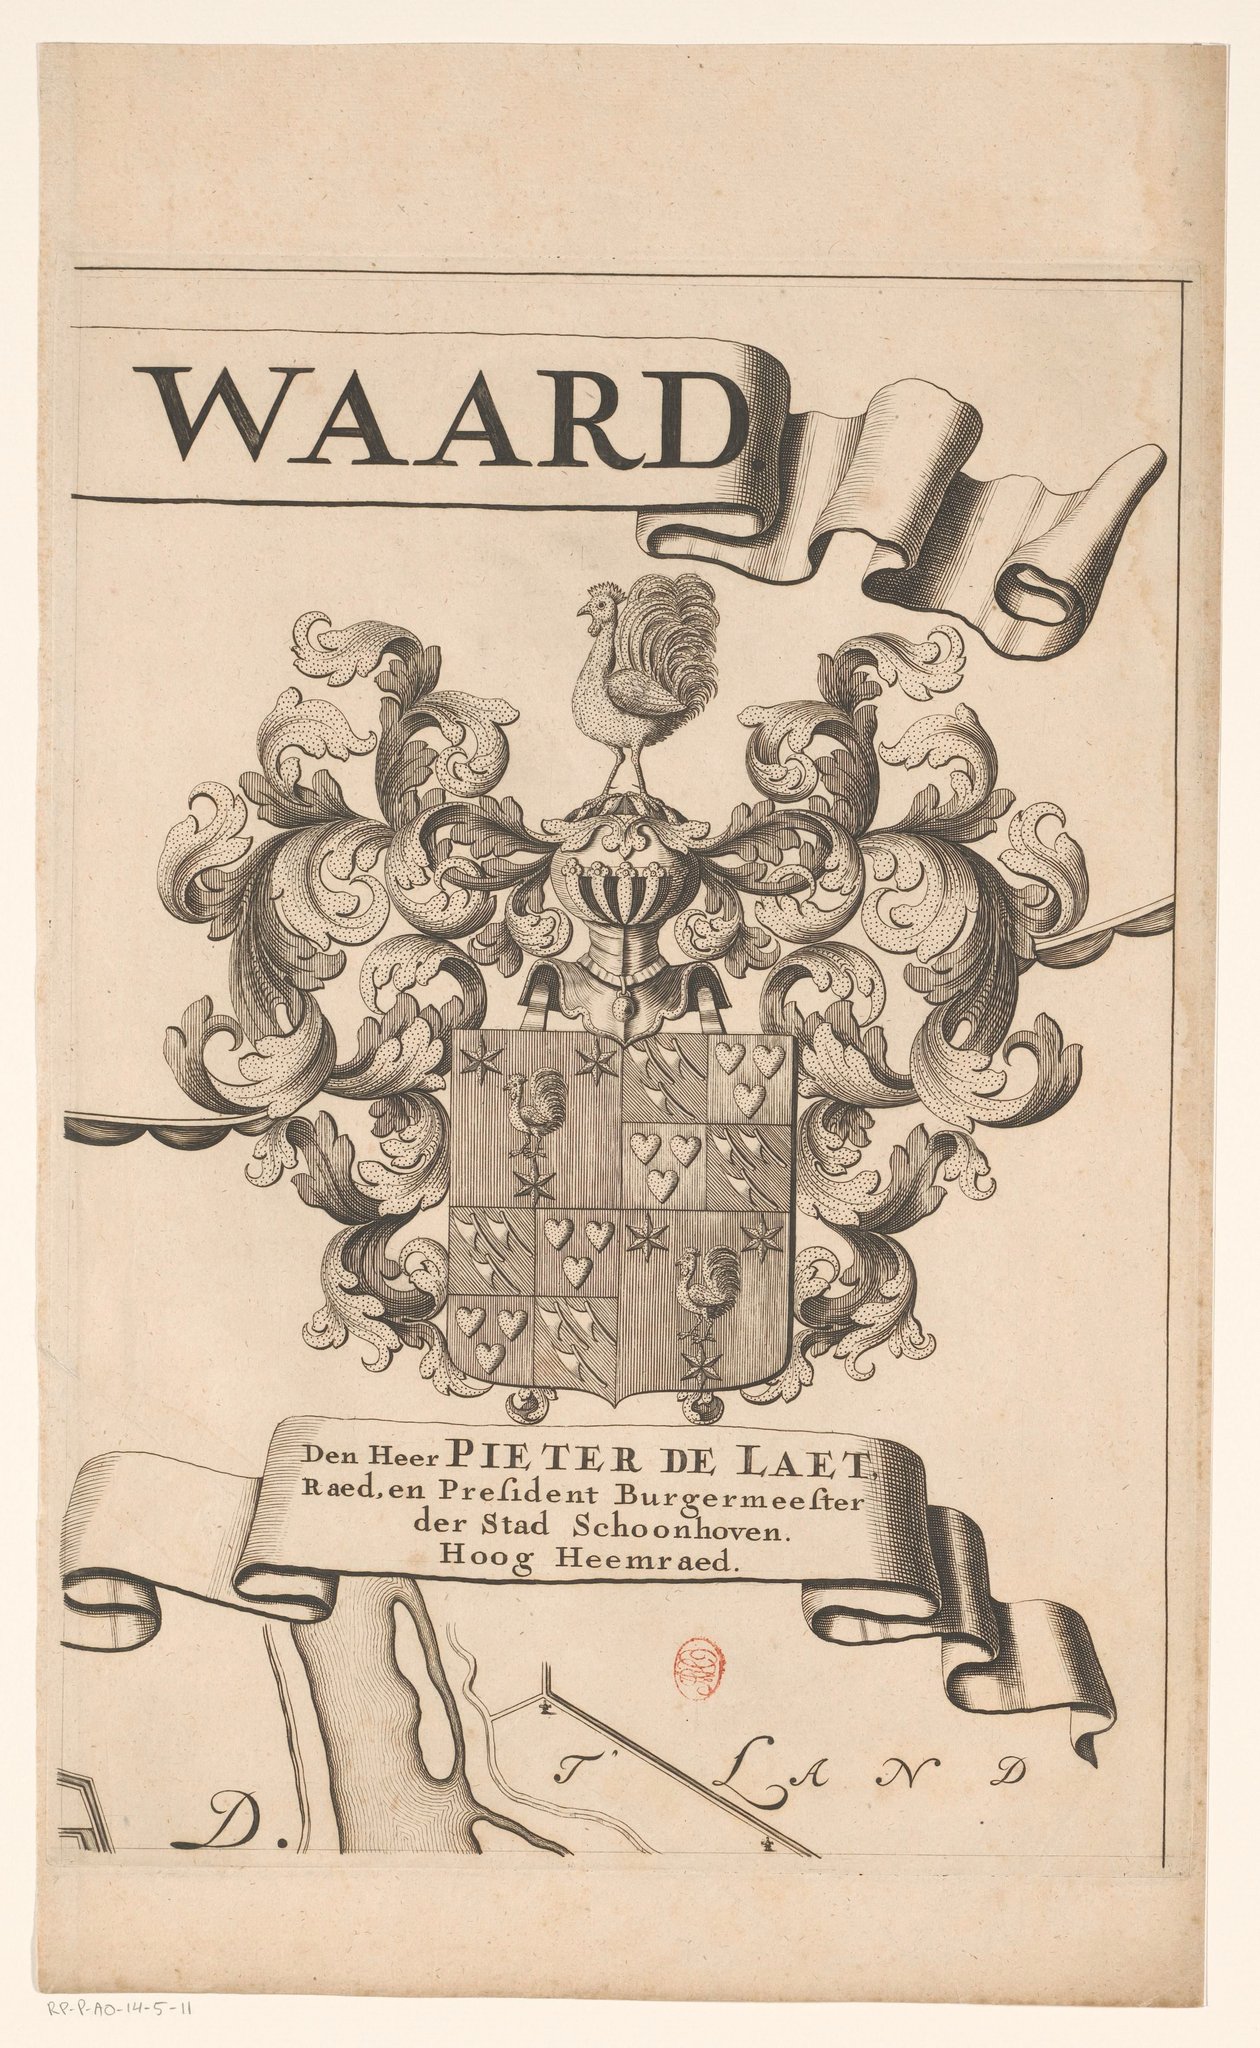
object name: print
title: Het Hooge Heemraadschap vande Crimpenre Waard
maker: Anonymous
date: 1683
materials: paper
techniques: engraving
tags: maps of separate countries or regions, armorial bearing, heraldry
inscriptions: collector's mark: Lugt 195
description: Deel van de wapenrand van de derde druk van 'Het Hooge Heemraadschap vande Crimpenre Waard', een wandkaart (bestaande uit een kaart en een wapenrand) van het Hoogheemraadschap van de Krimpenerwaard.